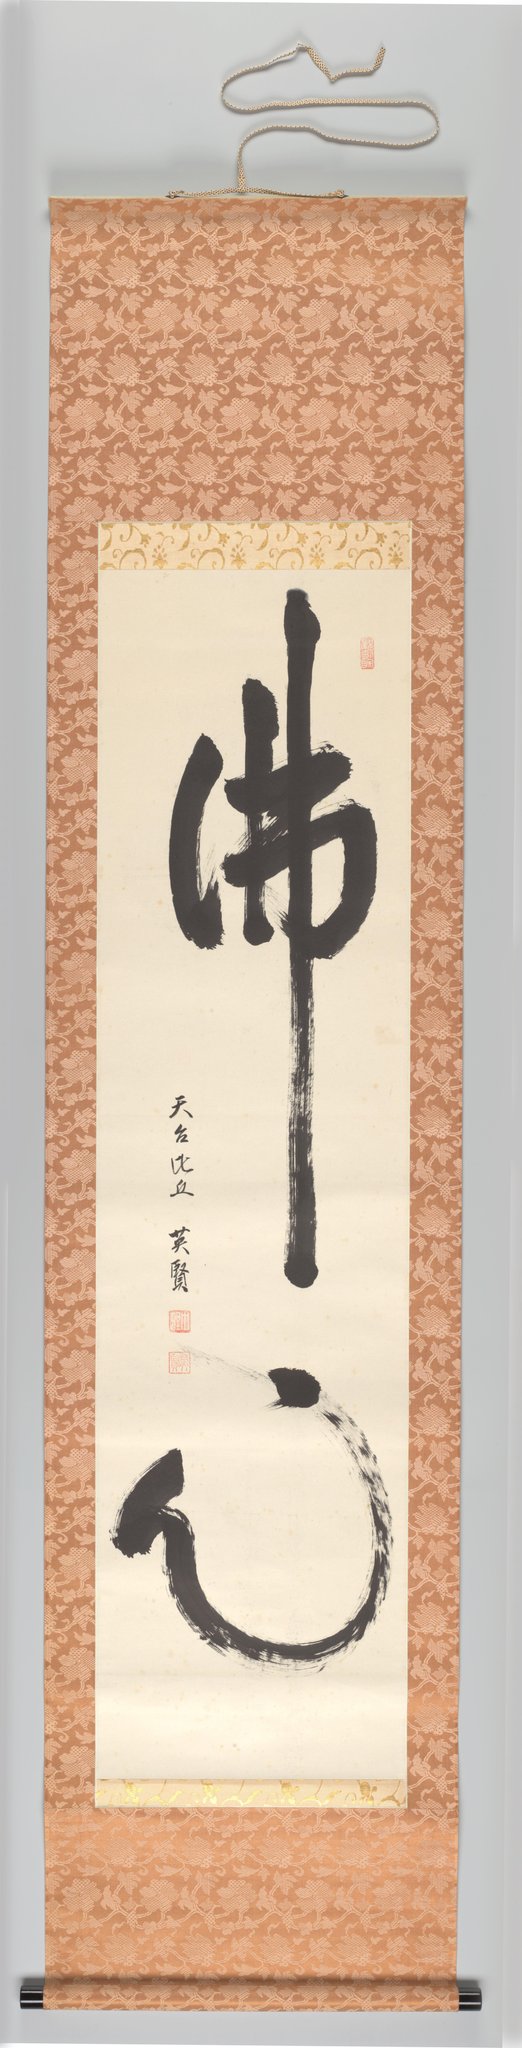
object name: hanging scroll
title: Buddha Heart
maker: nakano eiken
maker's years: 1933-2002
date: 1933-2002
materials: ink, paper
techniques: calligraphy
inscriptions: inscription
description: The monk Eiken here calligraphed the concept of the ‘Buddha heart’ or ‘Buddha mind’ in clear, open manner. The concept refers to the Buddha nature within all of us; the idea that enlightenment is potentially present in all beings. Form and content work together to convey the message as directly as possible. After all, Zen paintings are first and foremost teaching aids.